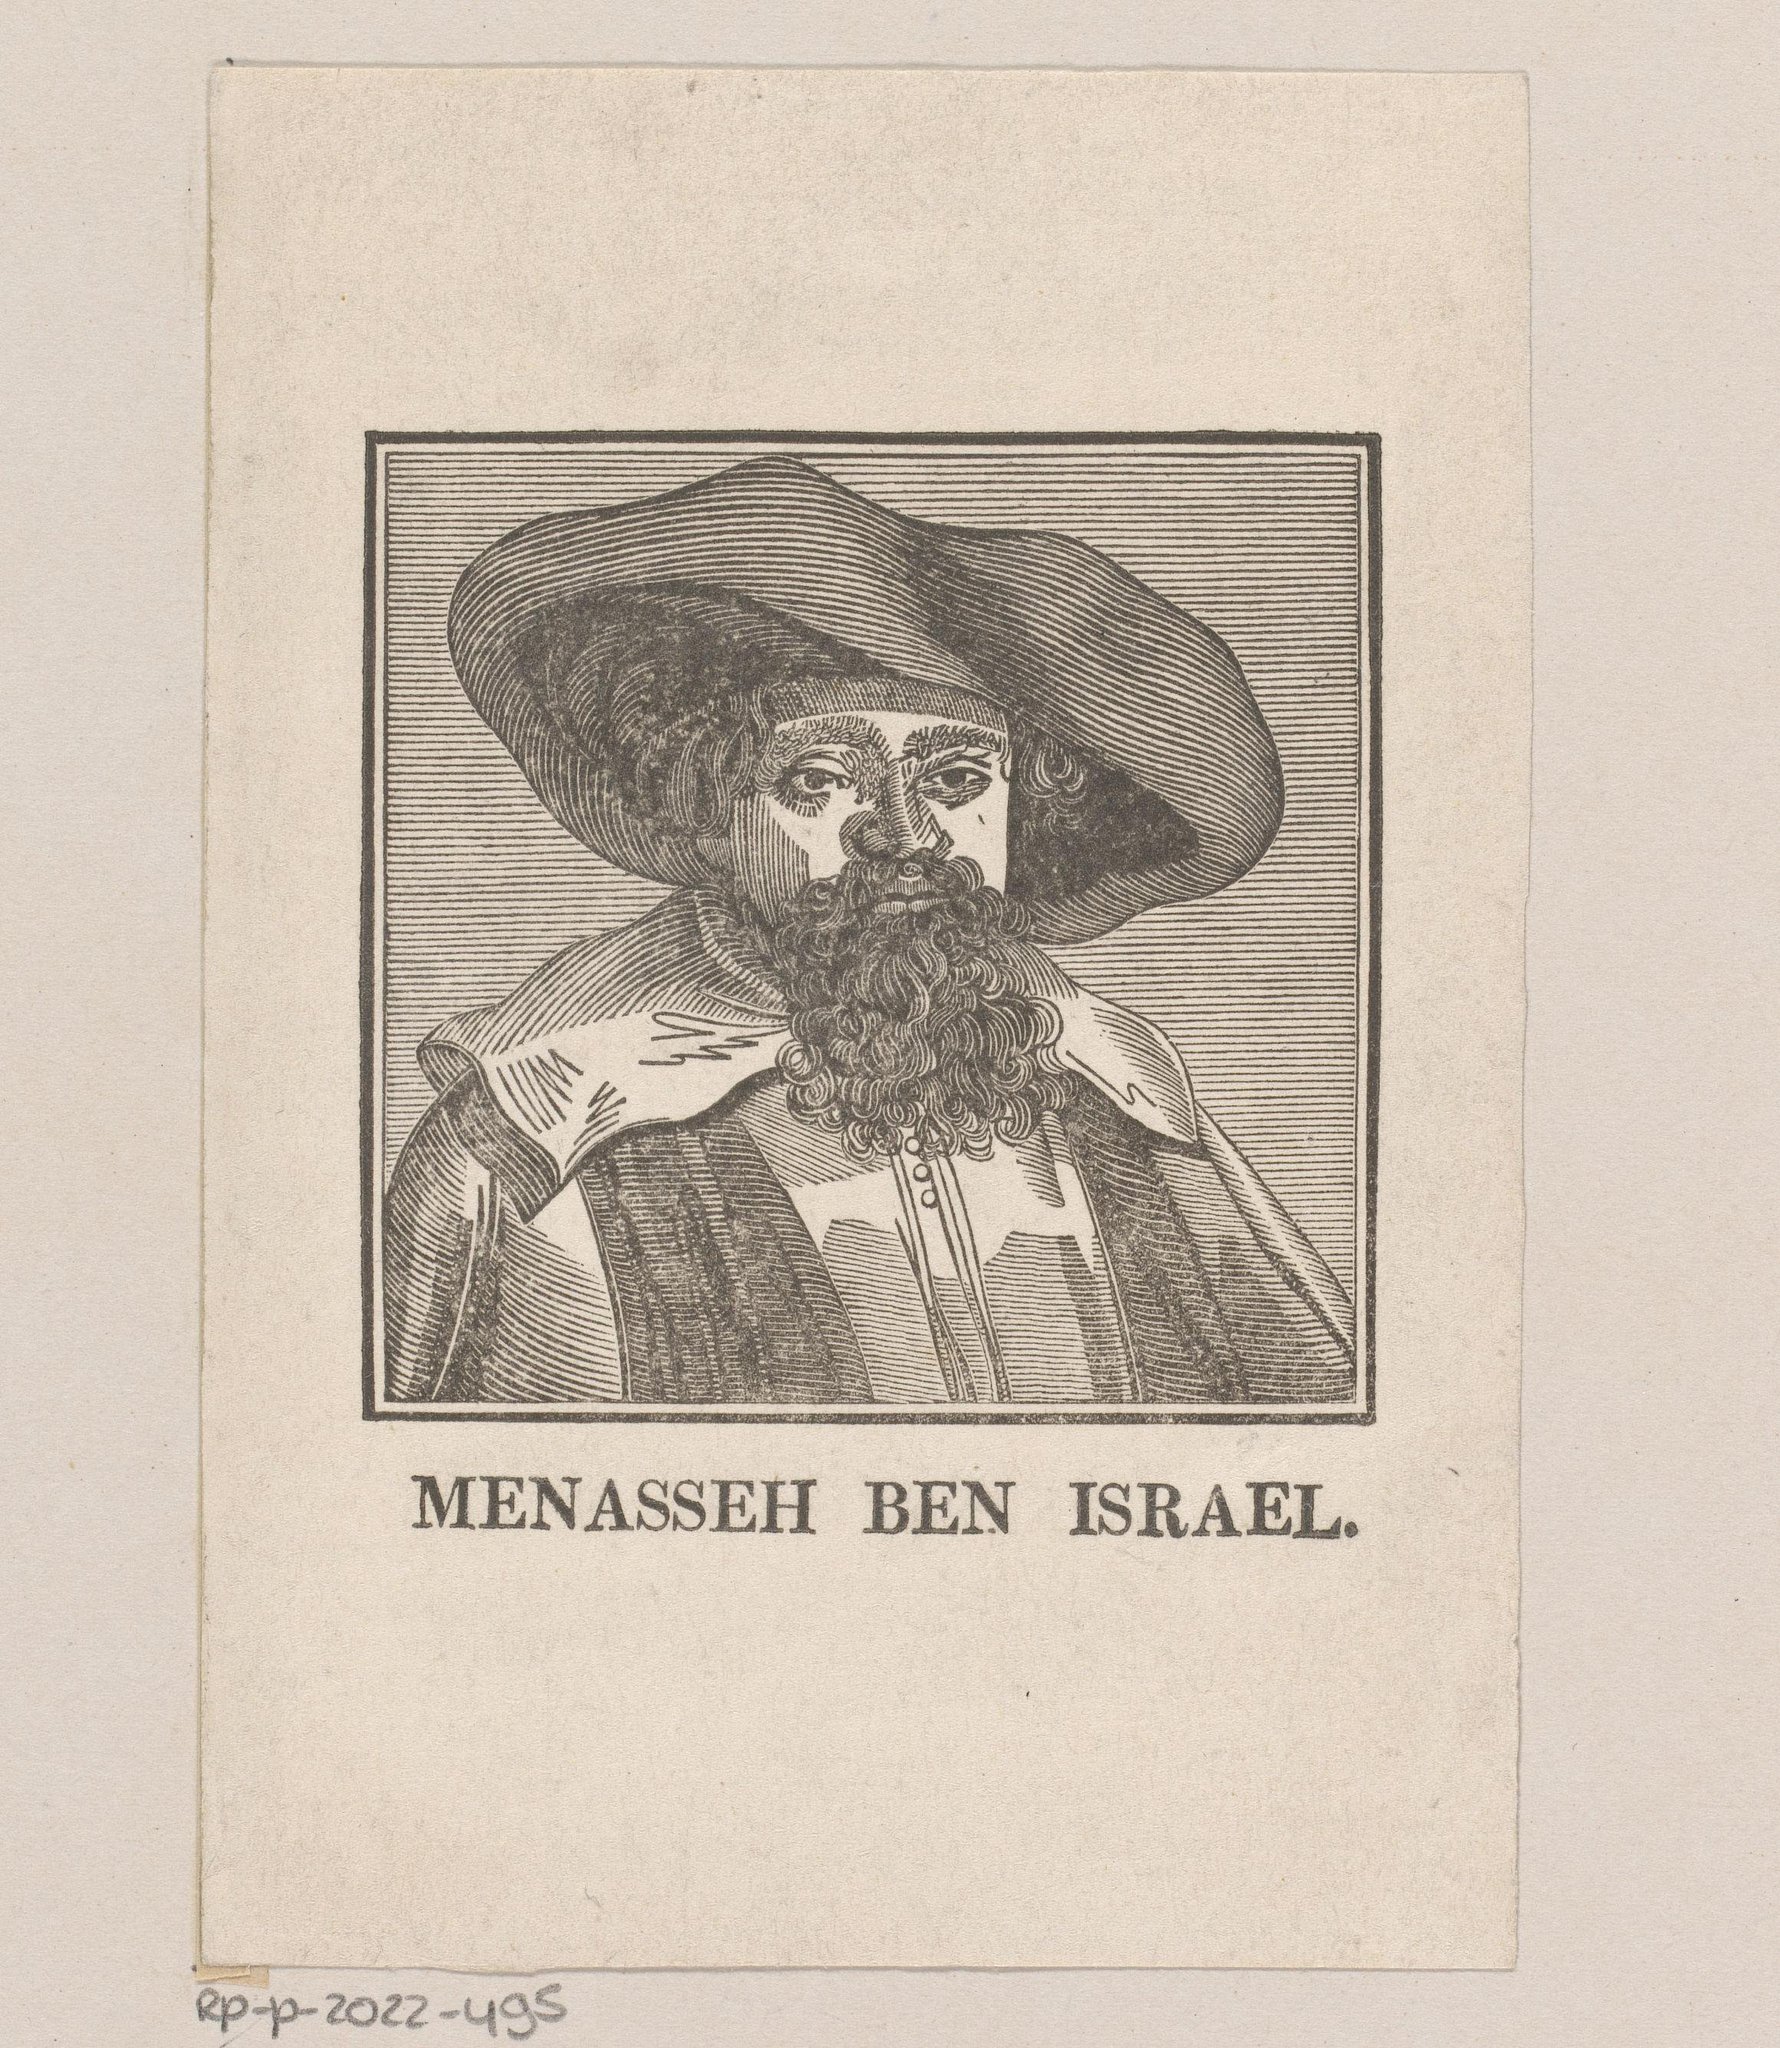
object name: print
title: Portret van Menasseh Ben Israel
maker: Anonymous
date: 1700-1900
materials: paper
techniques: woodcut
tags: historical persons